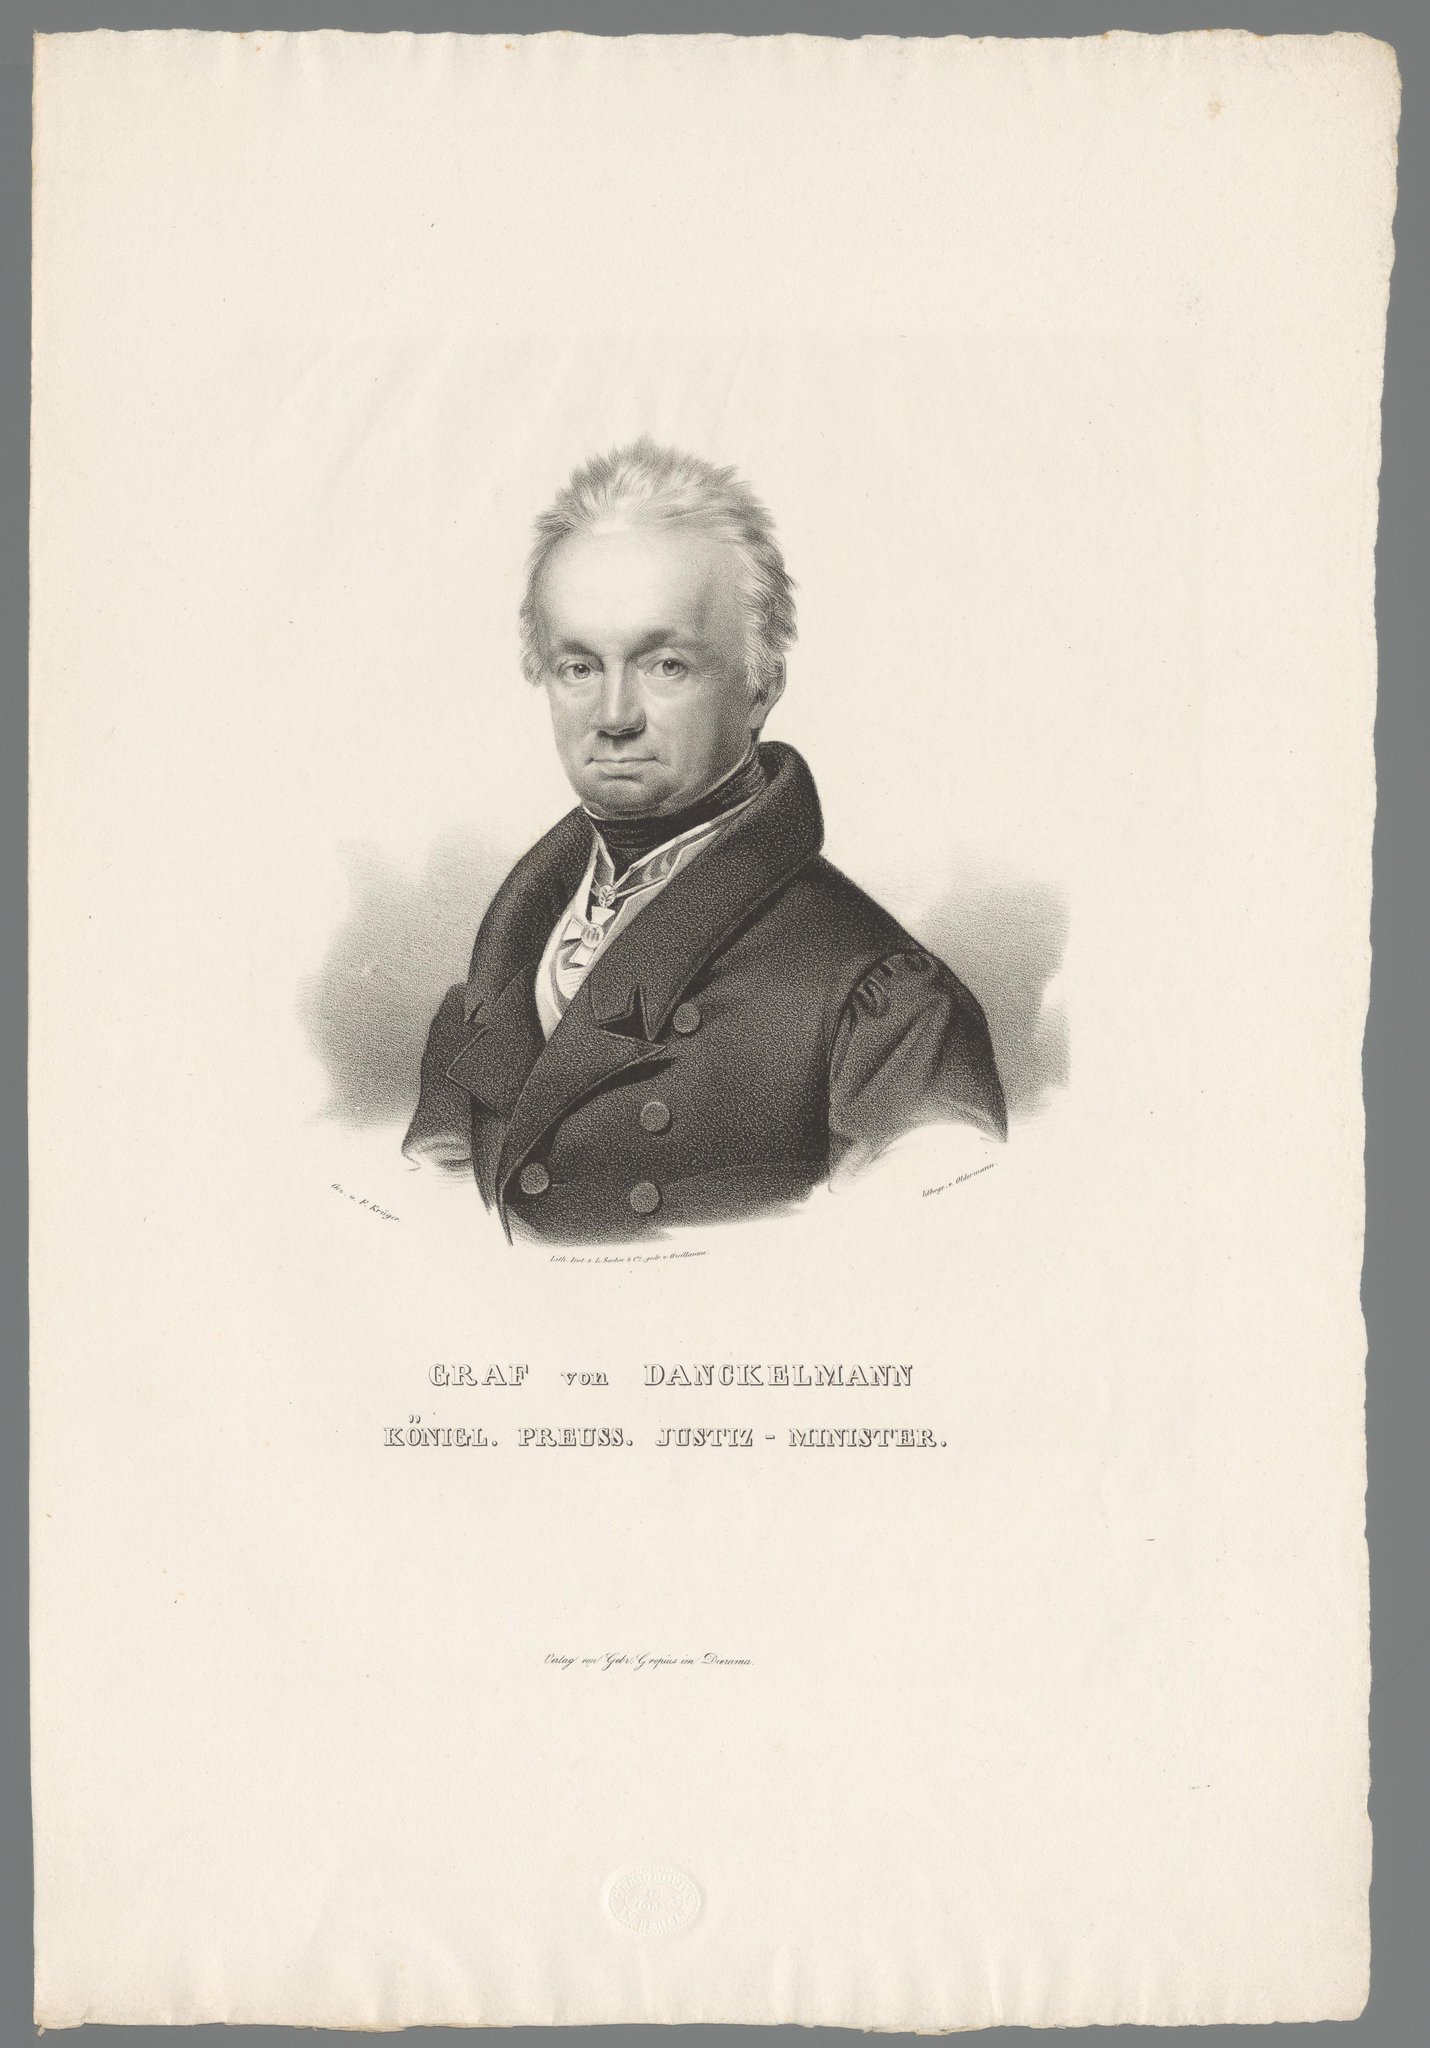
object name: print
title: Portret van Heinrich Wilhelm August Alexander graaf van Danckelmann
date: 1812-1874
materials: paper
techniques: lithograph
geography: berlin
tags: cleves, minister ~ government, historical persons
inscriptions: collector's mark: Lugt 2228, check stamp: Lugt 5415